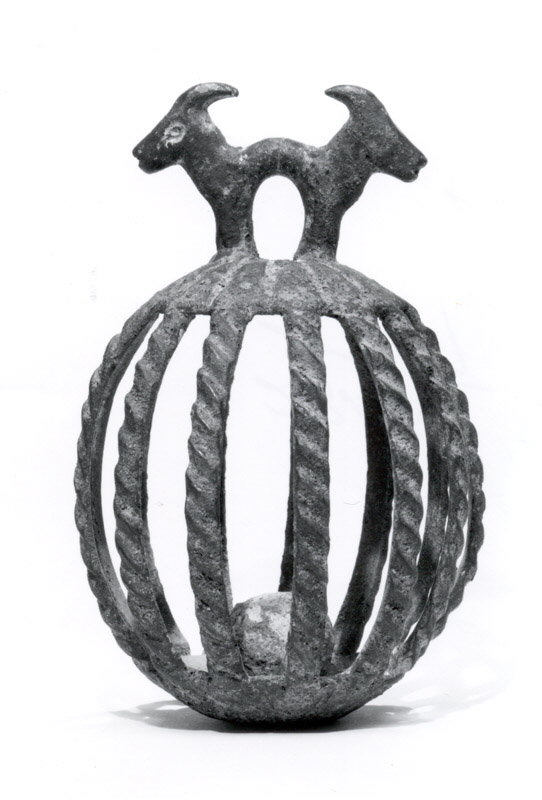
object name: rattle bell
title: Openwork rattle bell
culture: iranian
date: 1000 BCE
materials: bronze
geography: western iran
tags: animals